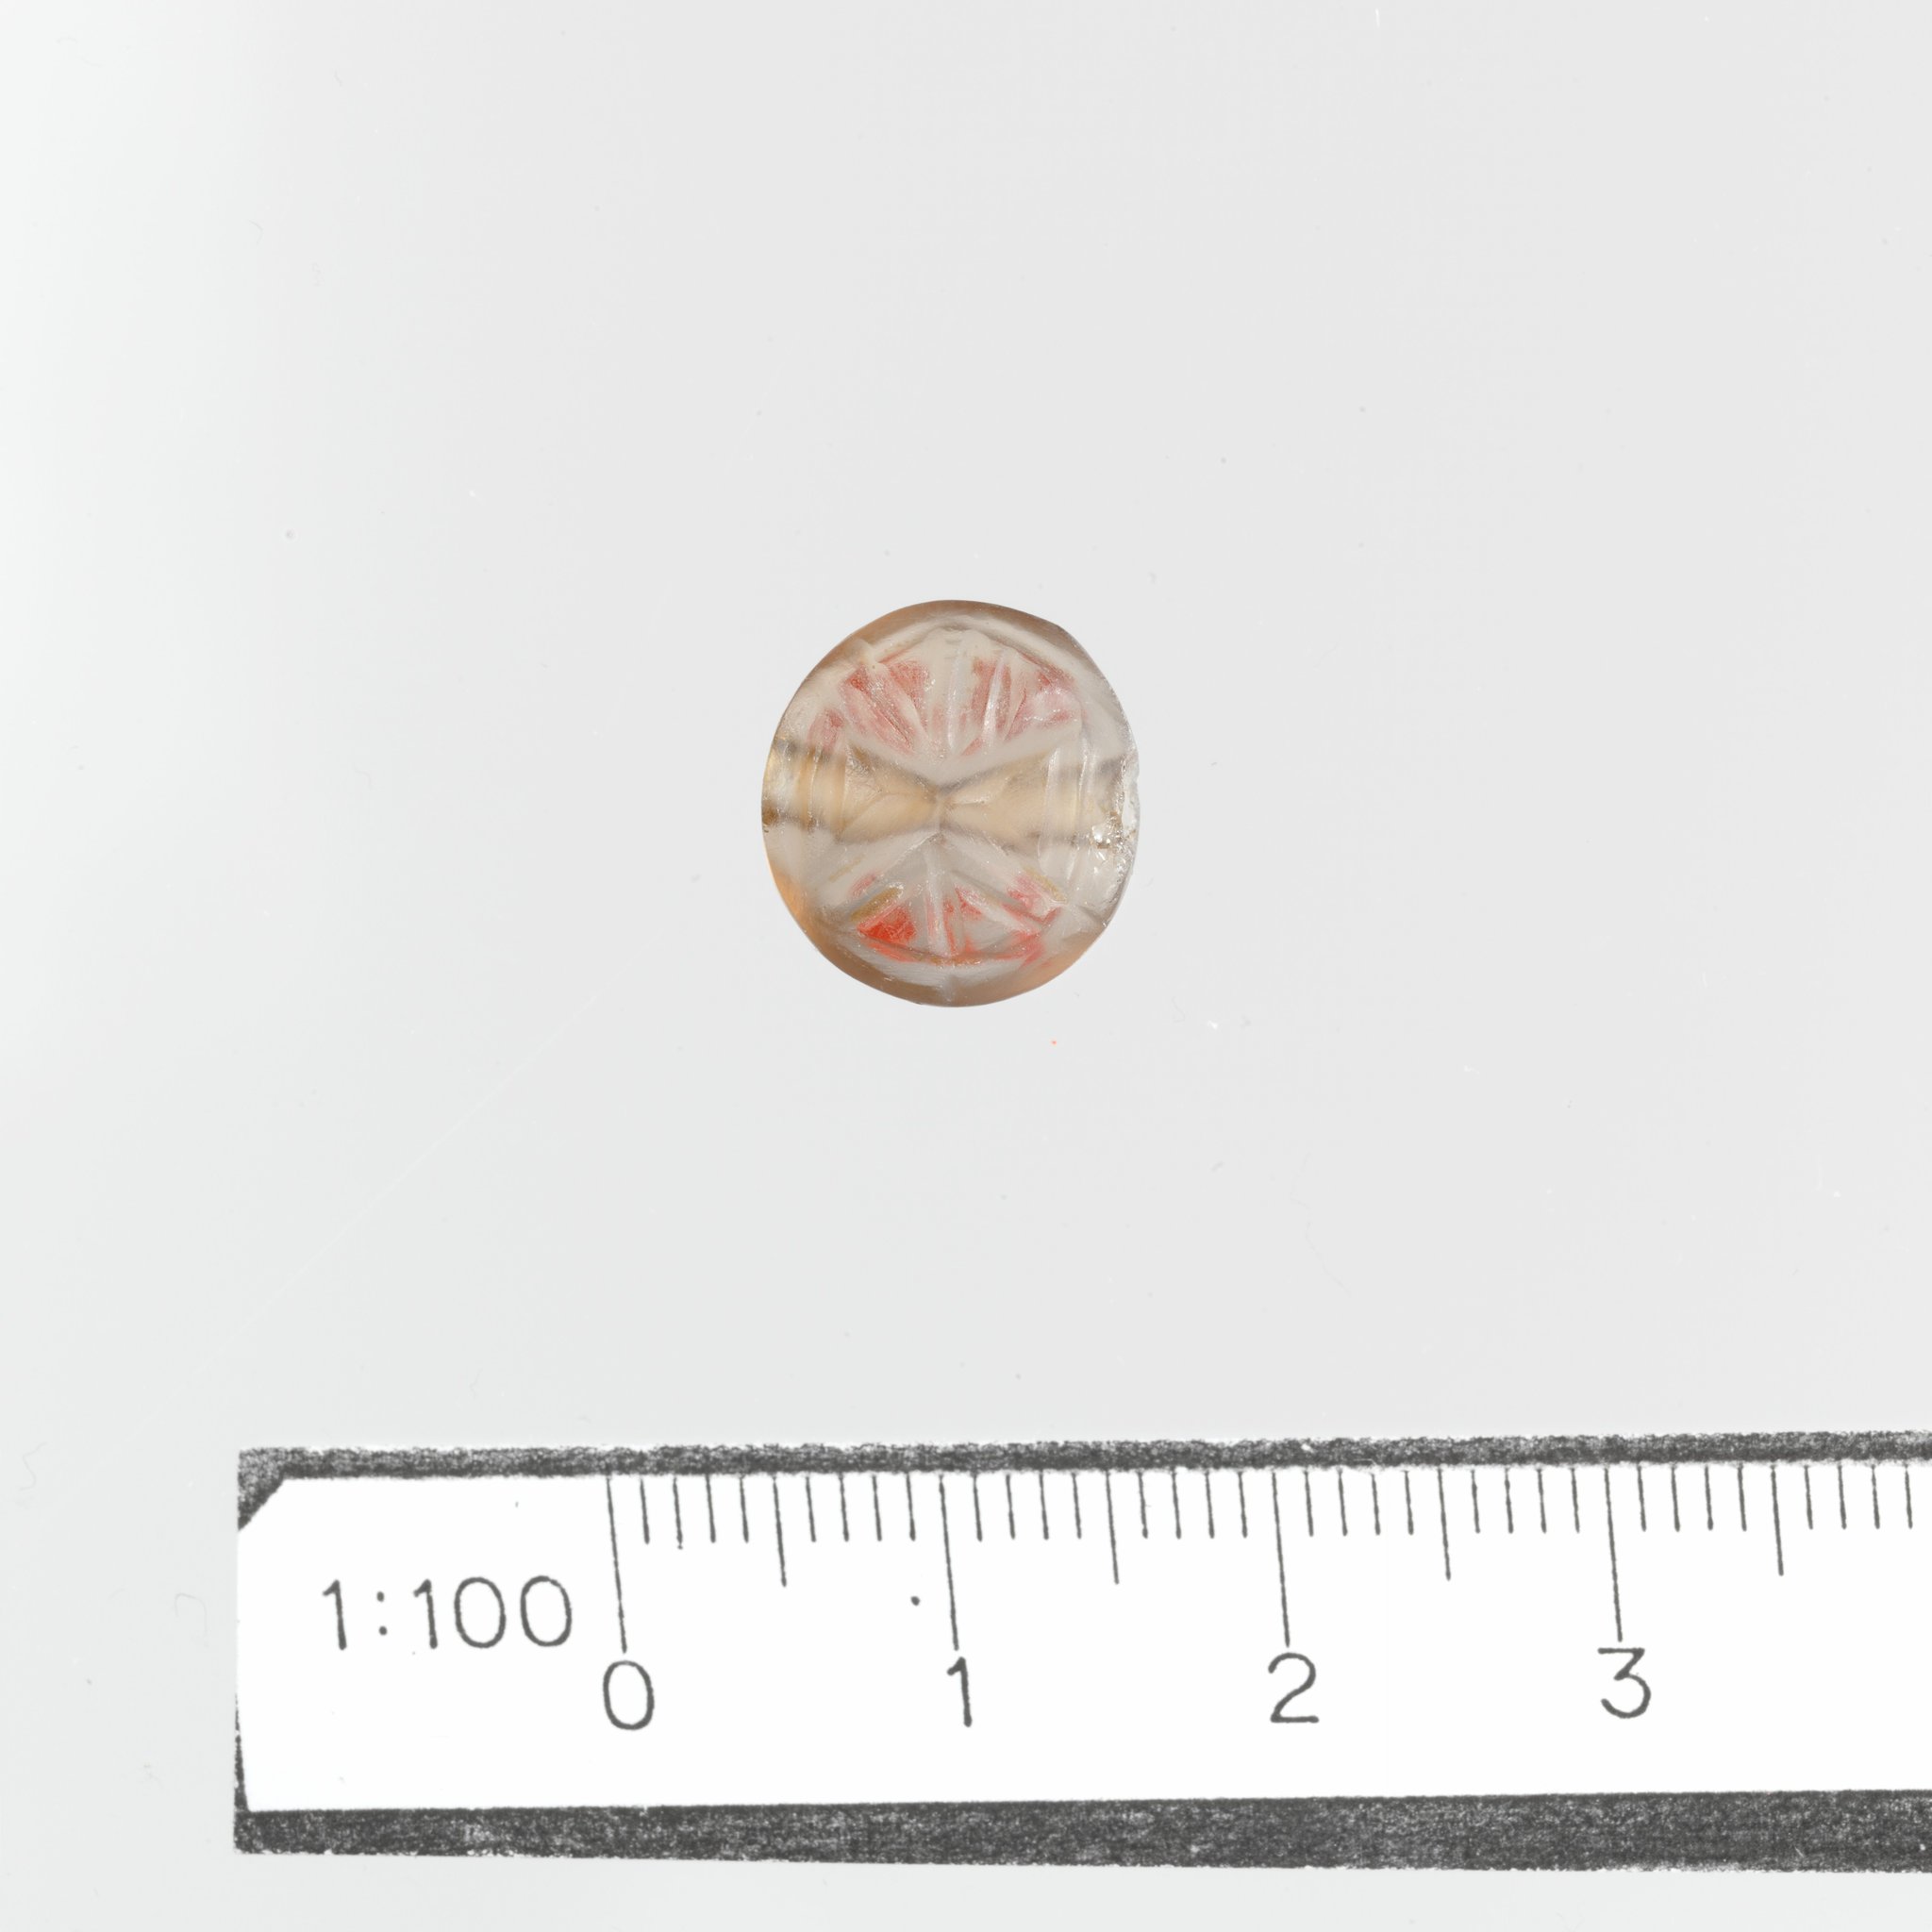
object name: seal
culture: minoan, crete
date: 2000-1450 BCE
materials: quartz